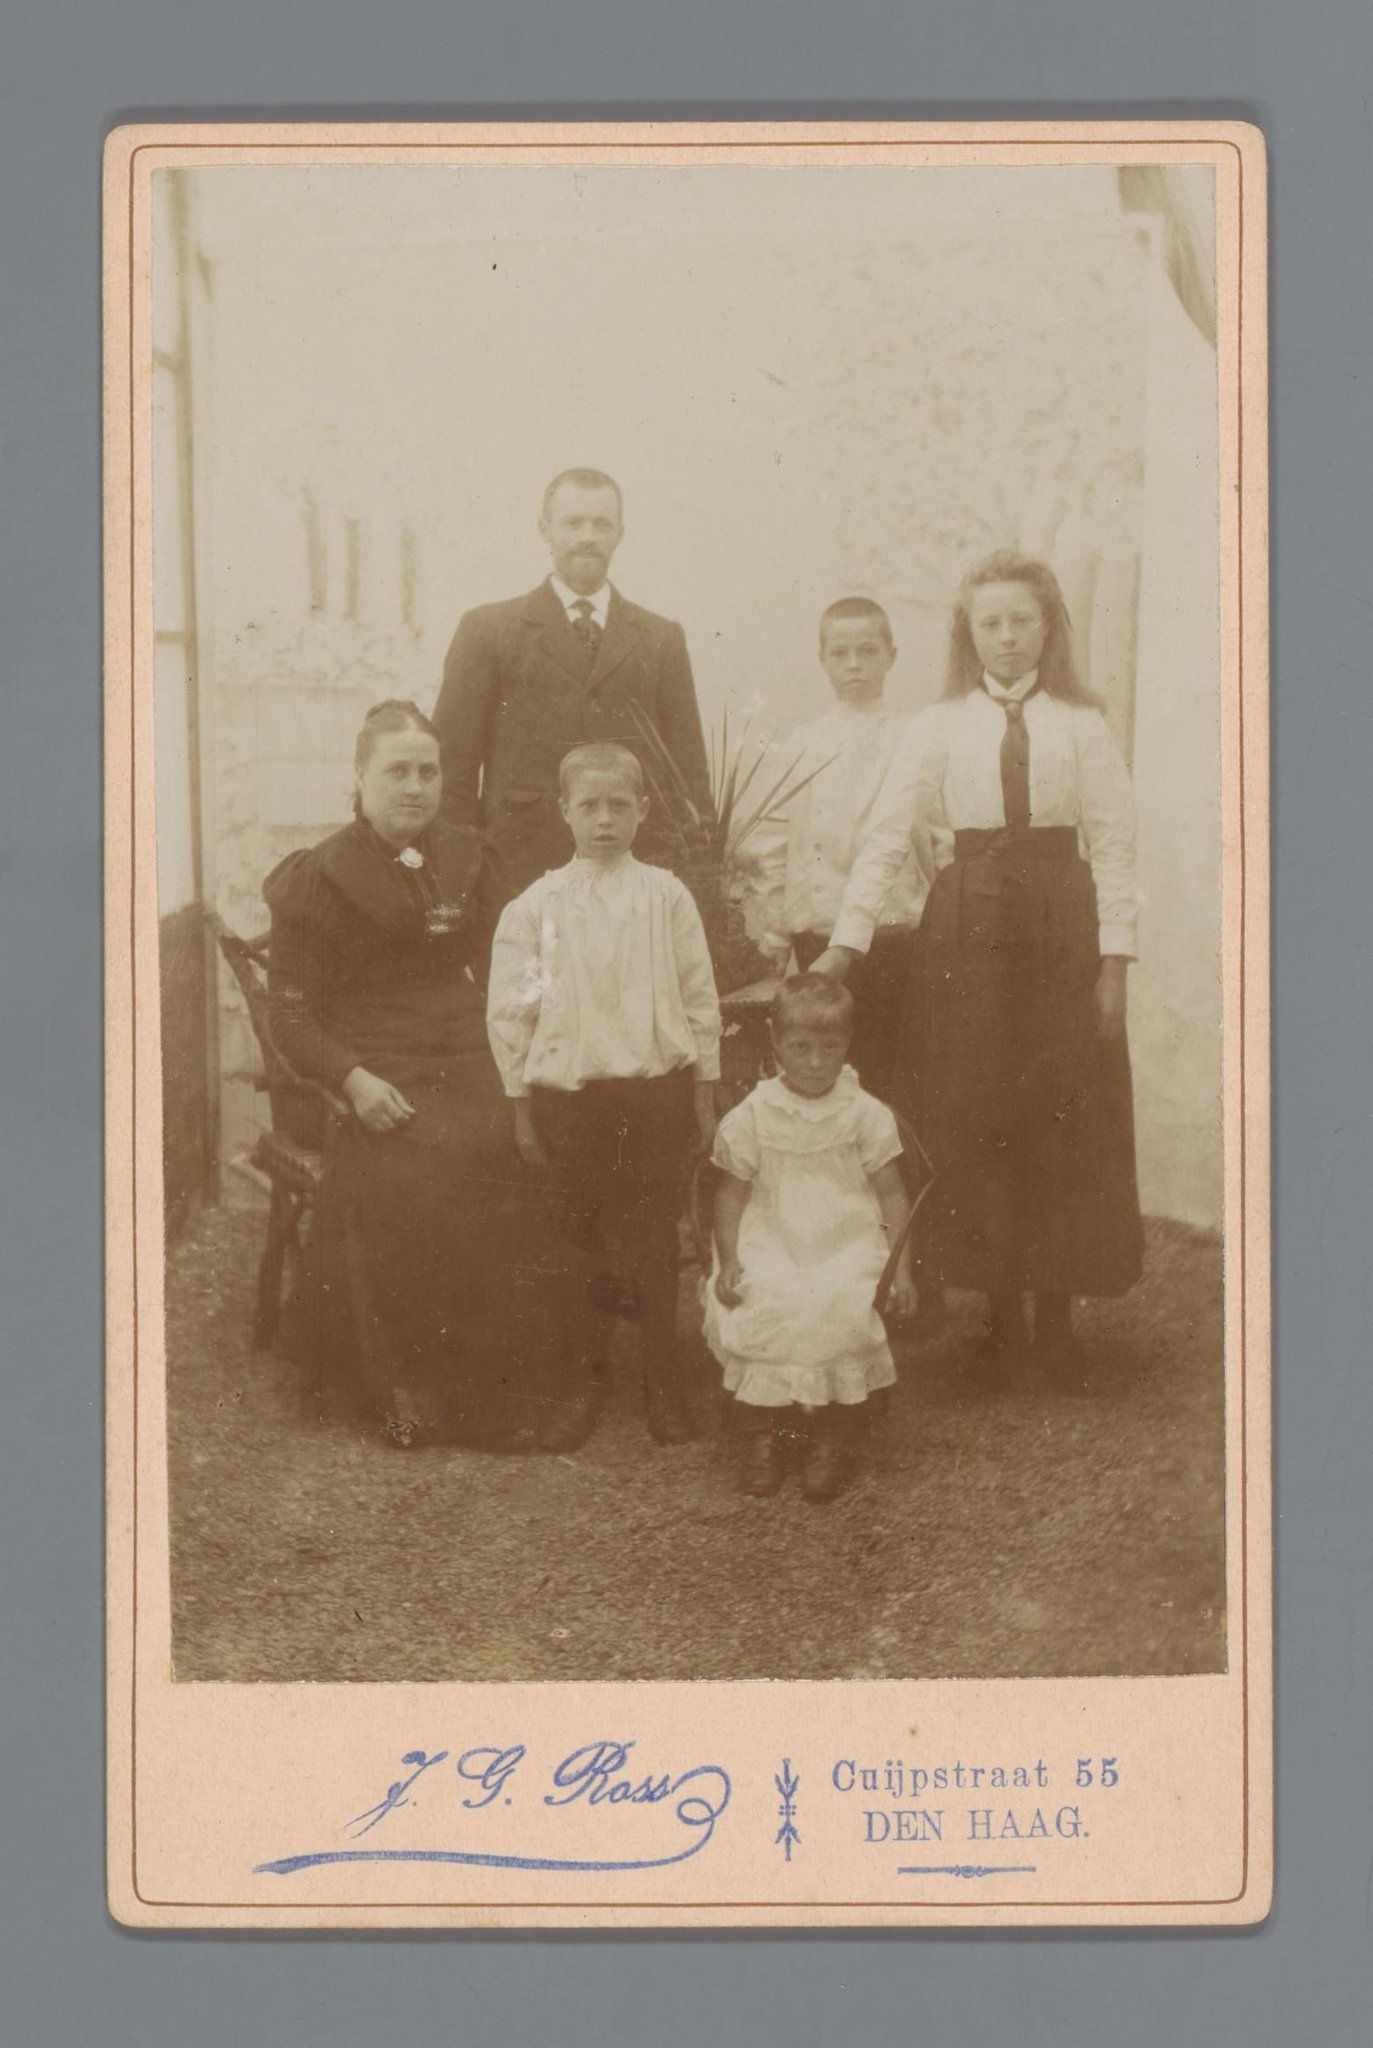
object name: cabinet photograph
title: Portret van een onbekend gezin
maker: johan george ross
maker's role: fotograaf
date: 1900-1915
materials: cardboard, photographic support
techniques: gelatin silver print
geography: the hague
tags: family group, especially parents with their child(ren)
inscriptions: name: ‘J.G. Ross Cuijpstraat 55 Den Haag’, inscription: ‘Voor Moeder.’